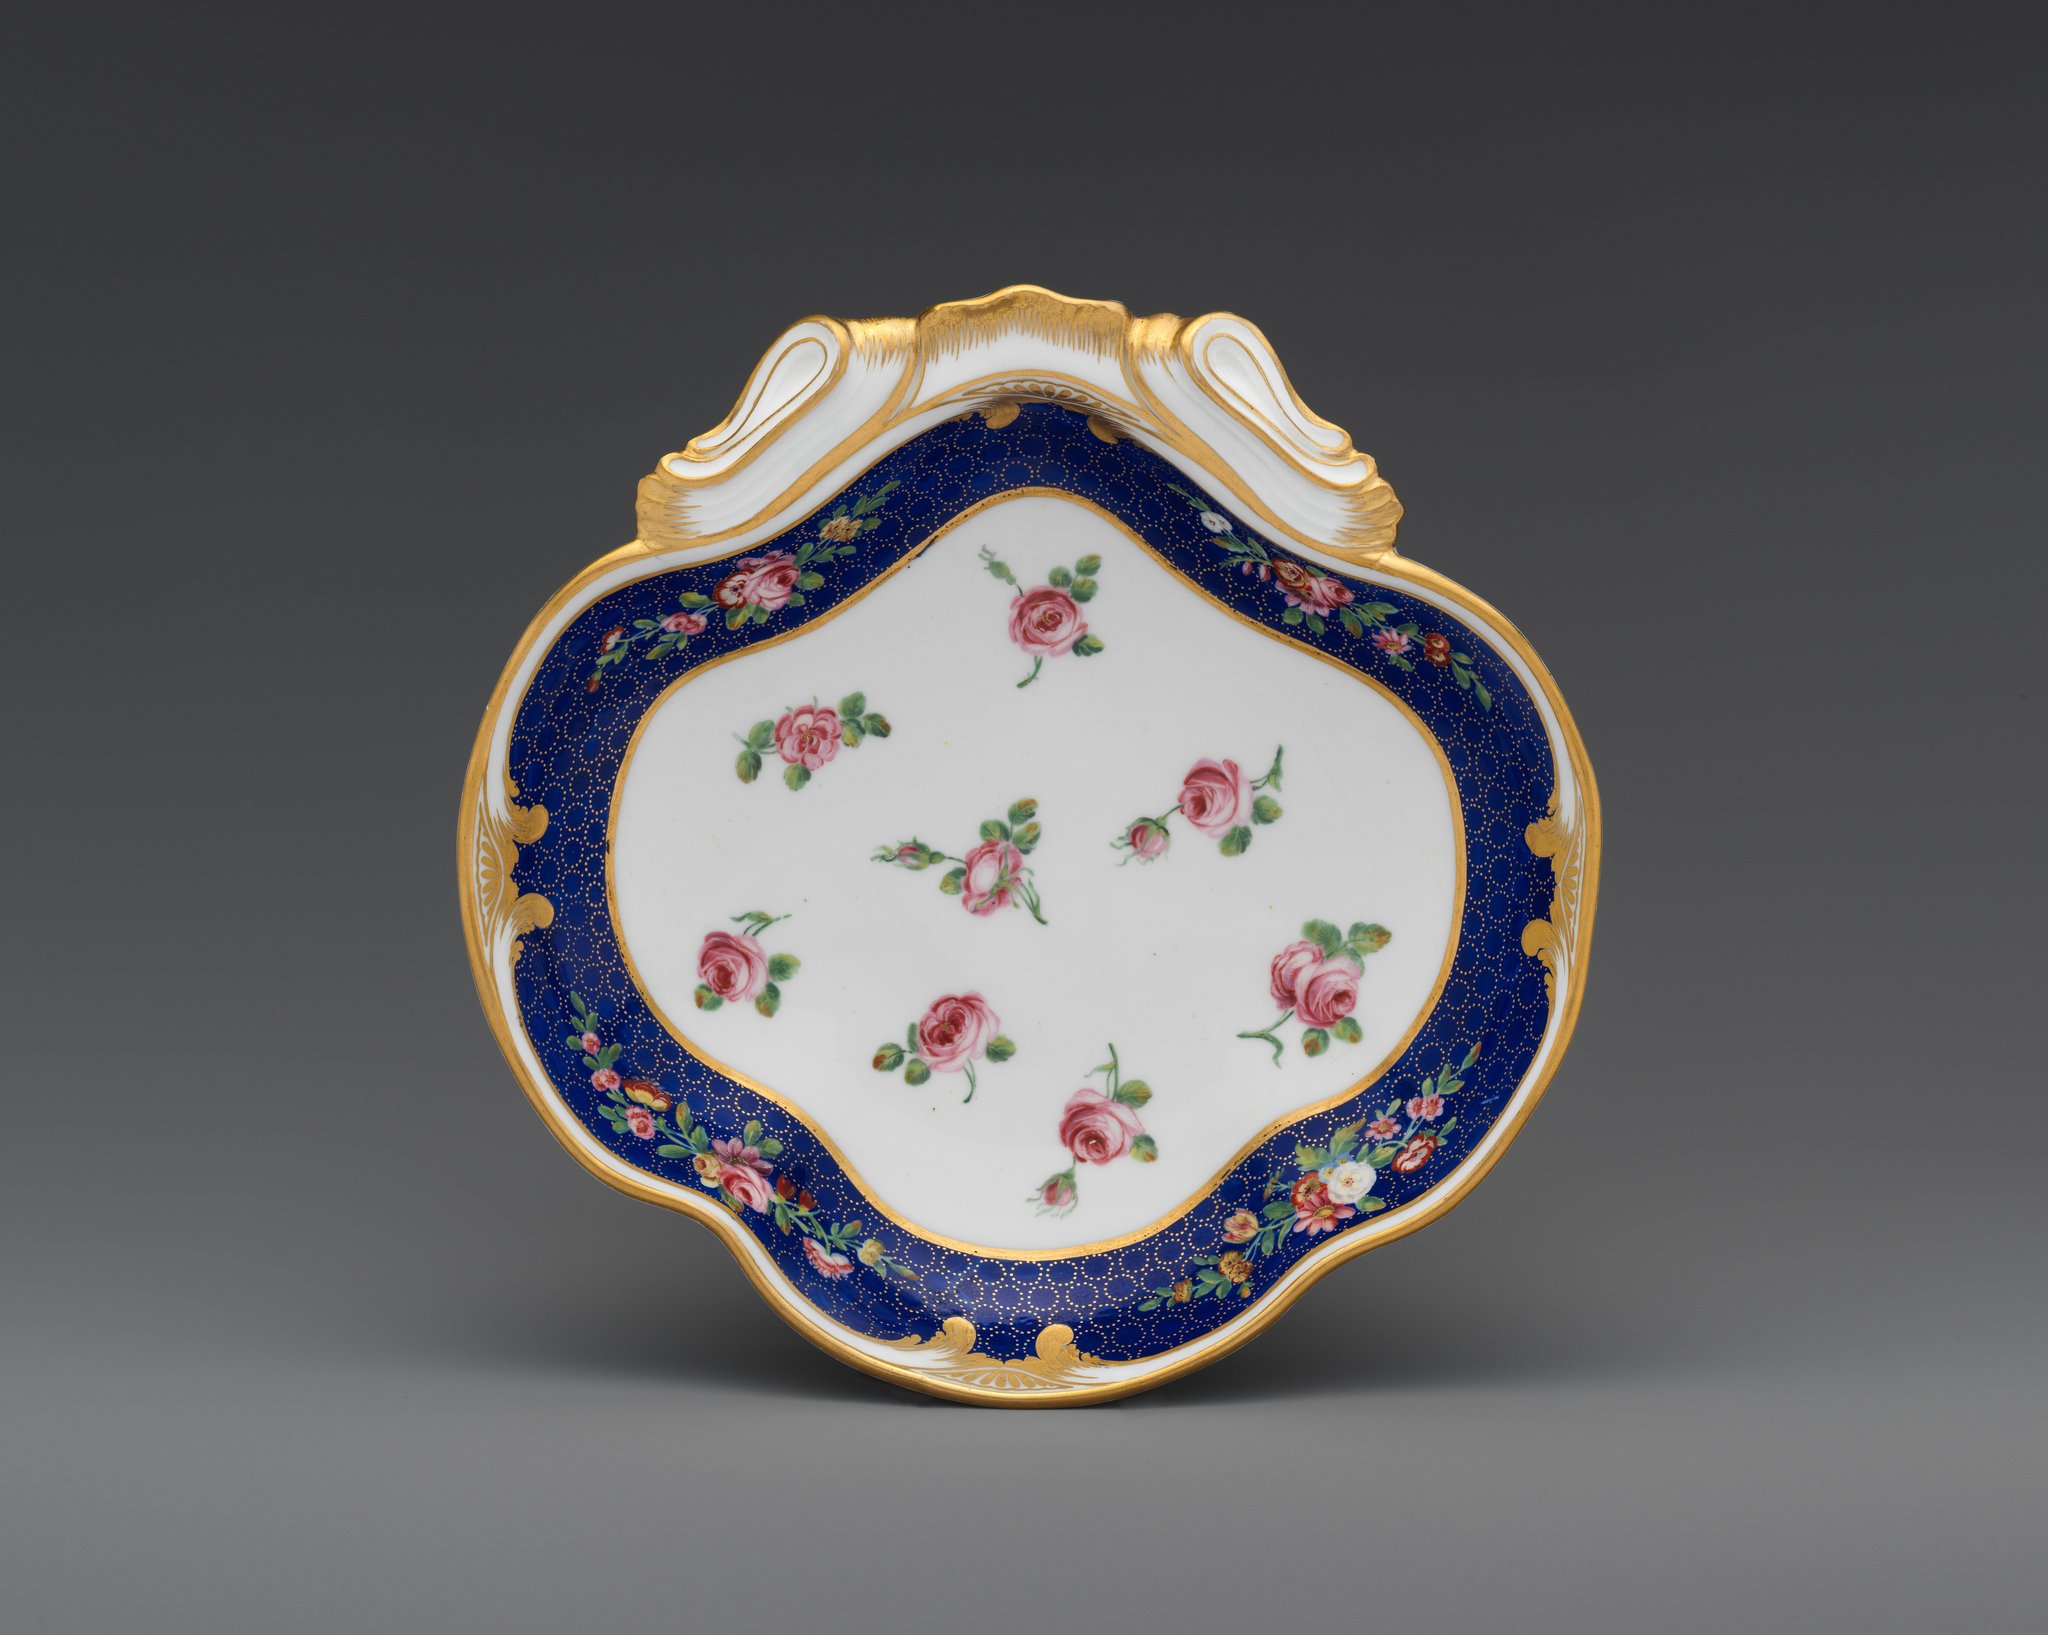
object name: fruit dish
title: Fruit dish (compotier à coquille)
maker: sèvres manufactory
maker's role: manufactory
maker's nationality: french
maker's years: 1740-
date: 1771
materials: soft paste porcelain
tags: roses